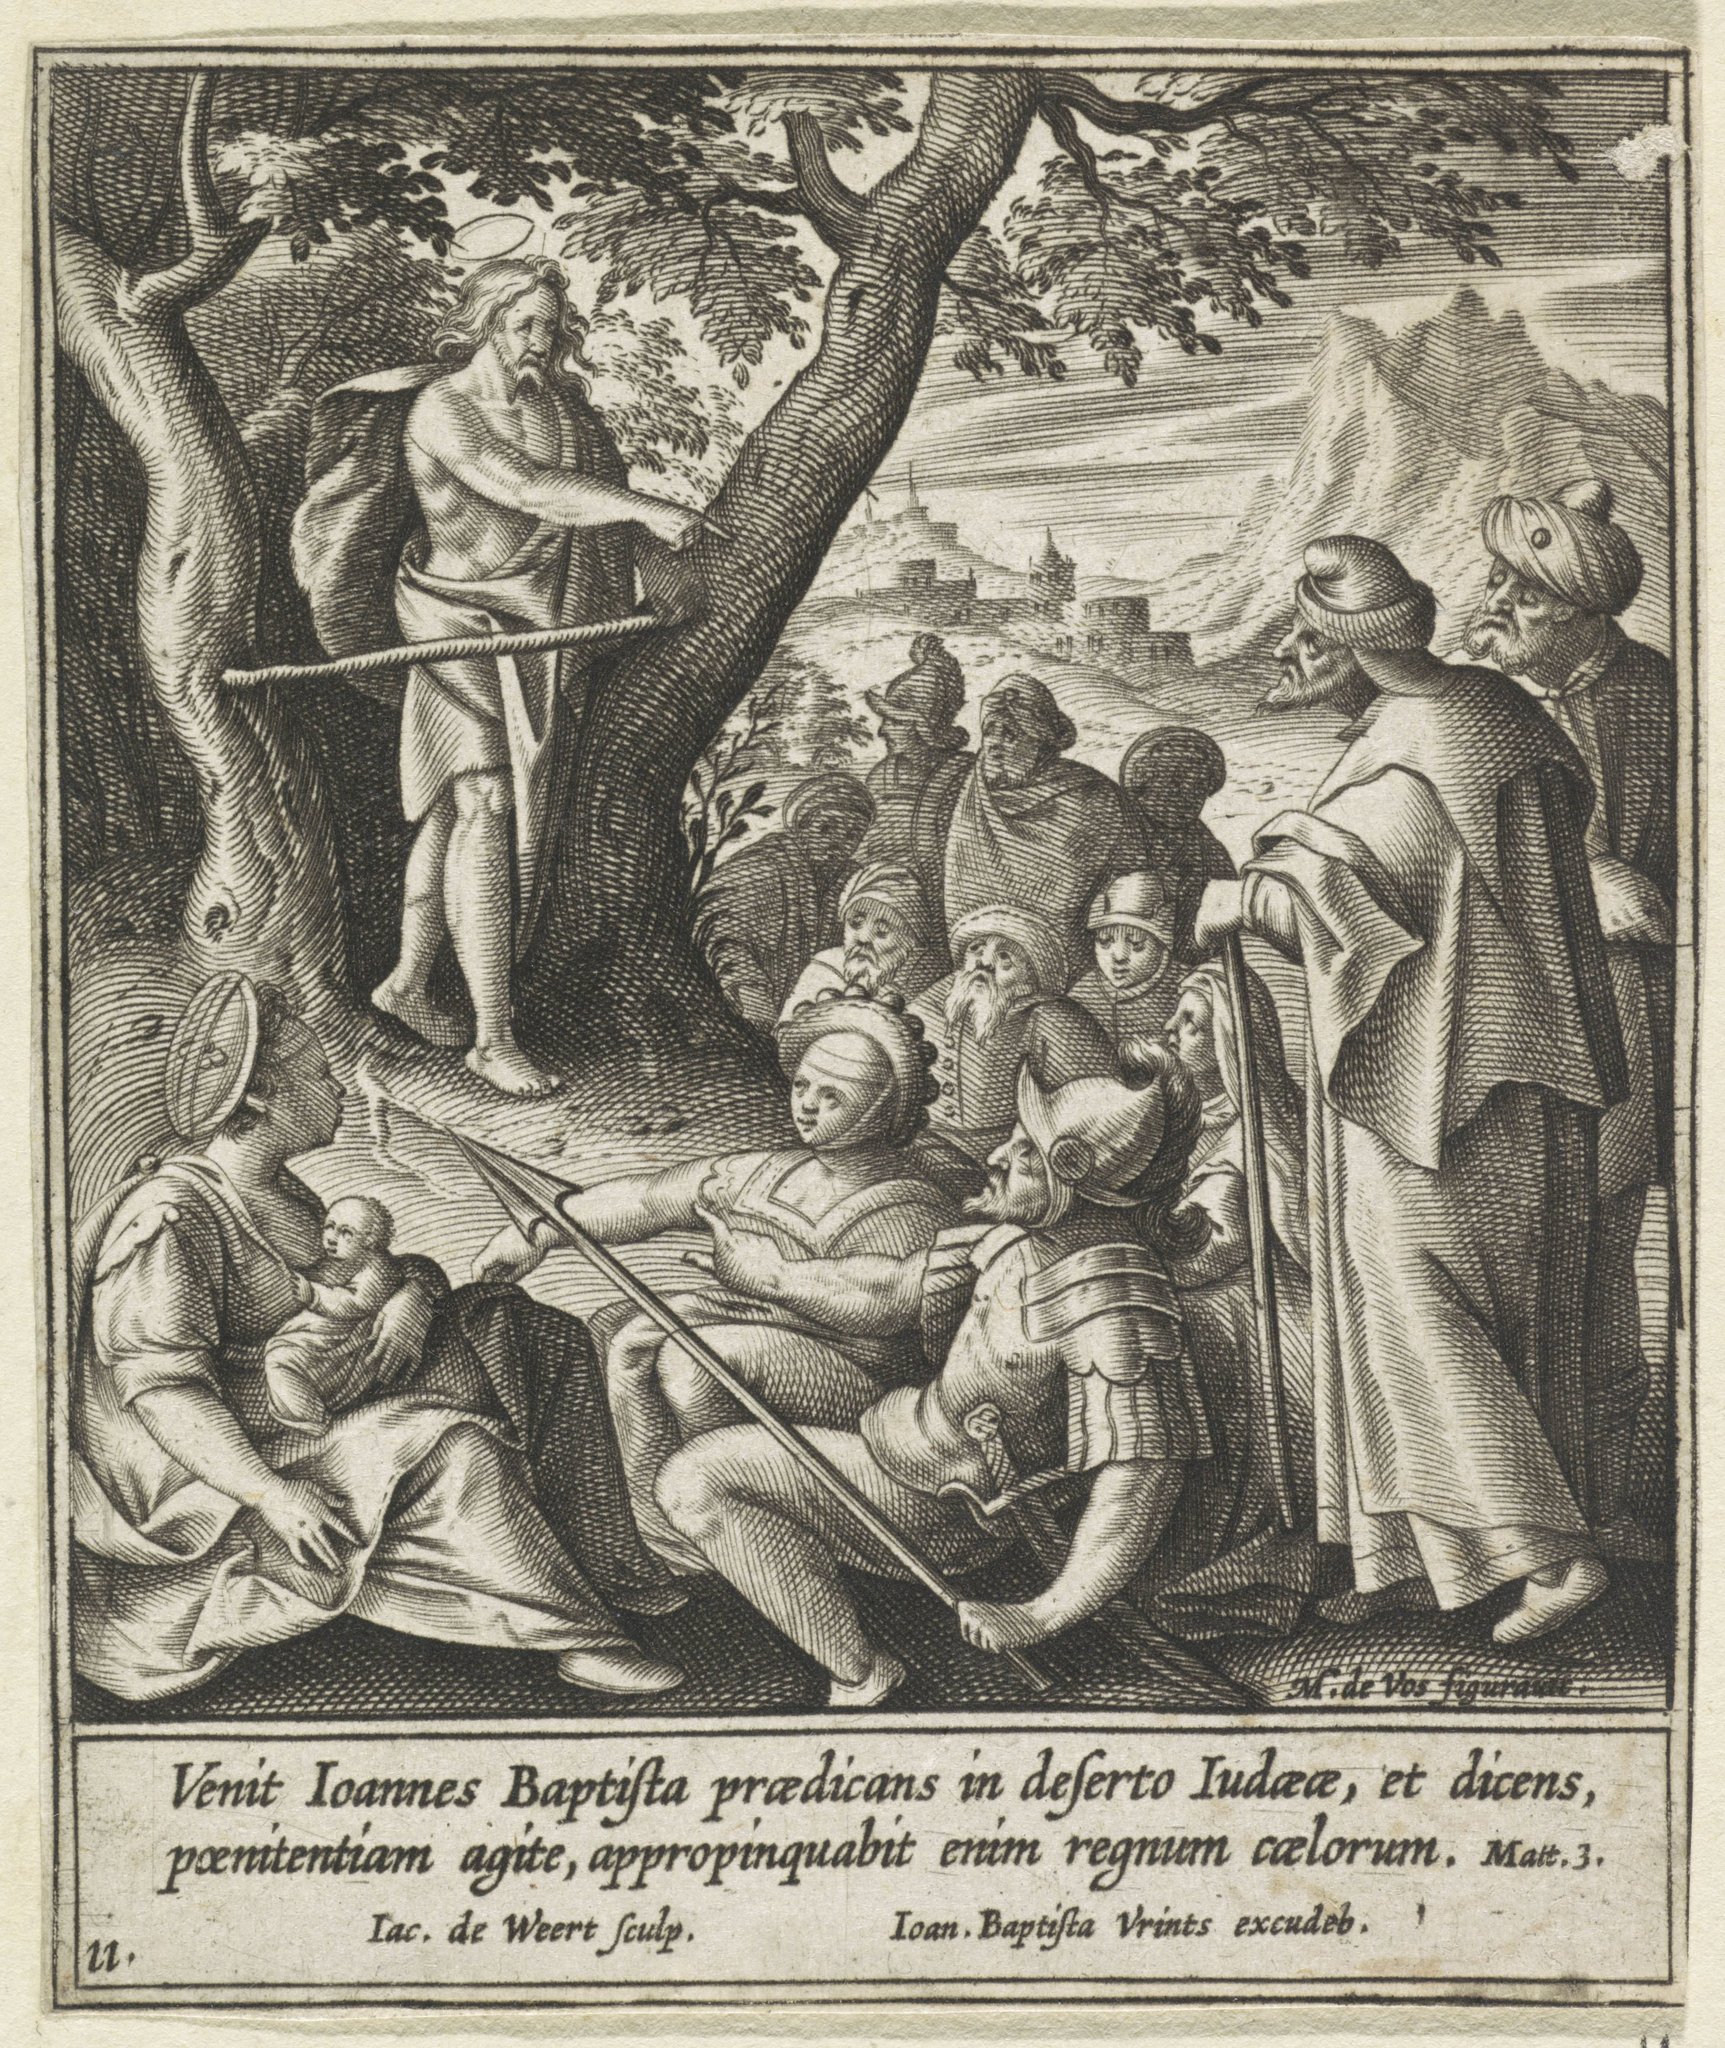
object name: print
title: Leven van Johannes de Doper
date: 1580-1600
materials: paper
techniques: engraving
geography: antwerp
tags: john the baptist in the wilderness, usually accompanied by a lamb, john the baptist preaching (perhaps christ among the bystanders)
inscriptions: collector's mark: Lugt 240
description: In de wildernis van Judea staat Johannes de Doper tussen twee bomen. Verschillende omstanders luisteren naar zijn preek. In de verte ligt de stad Jeruzalem aan de voet van een berg. Onder de voorstelling bevindt zich een tweeregelige, Latijnse tekst met de beschrijving van de scène uit Matt. 3.